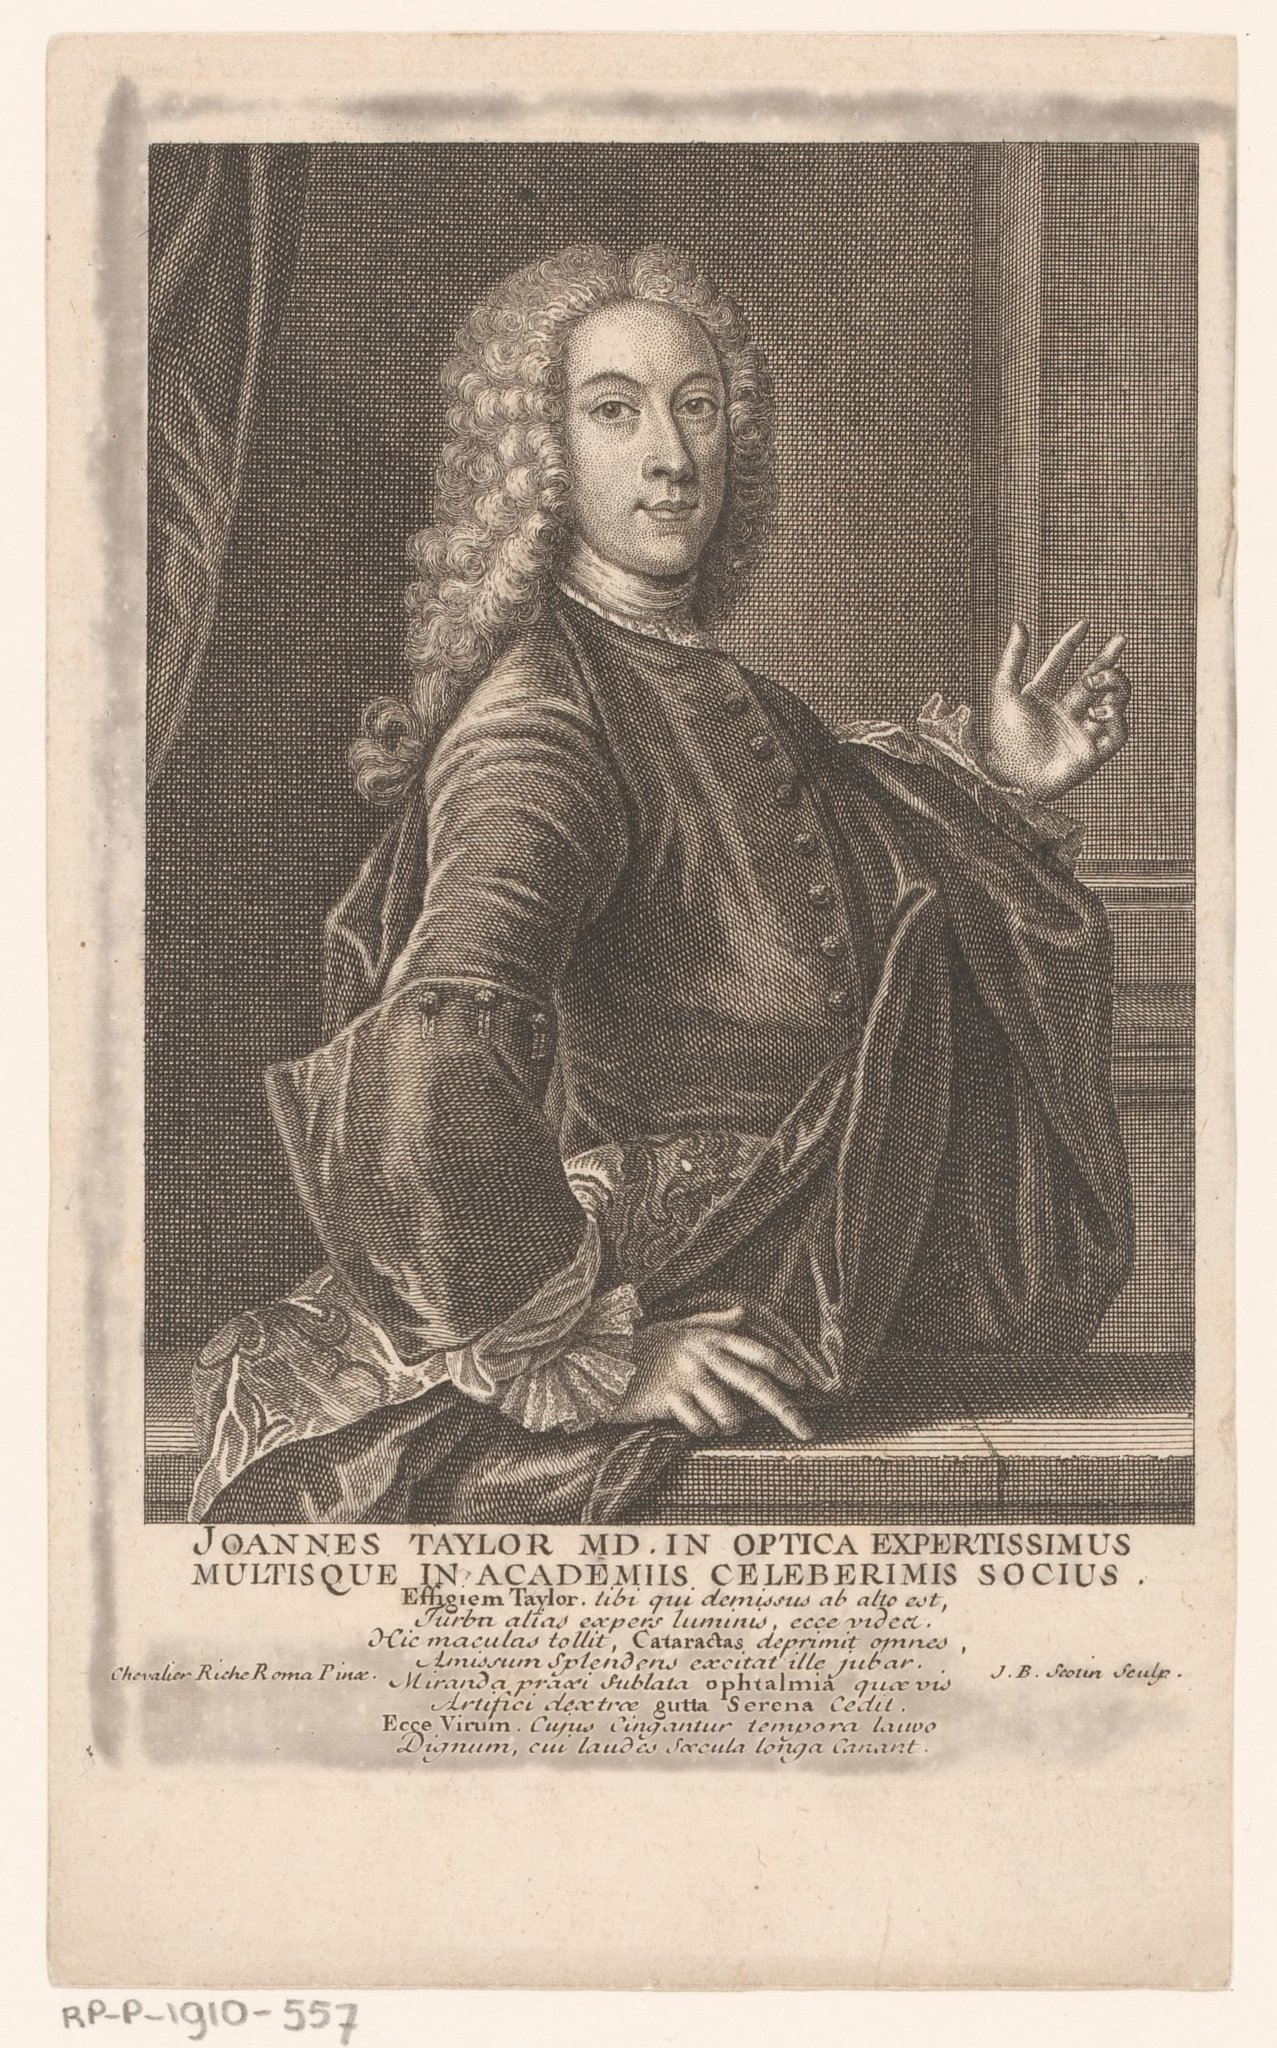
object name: print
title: Portret van John Taylor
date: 1688-1733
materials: paper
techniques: engraving, etching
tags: historical persons, physician, doctor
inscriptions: collector's mark: Lugt 2228